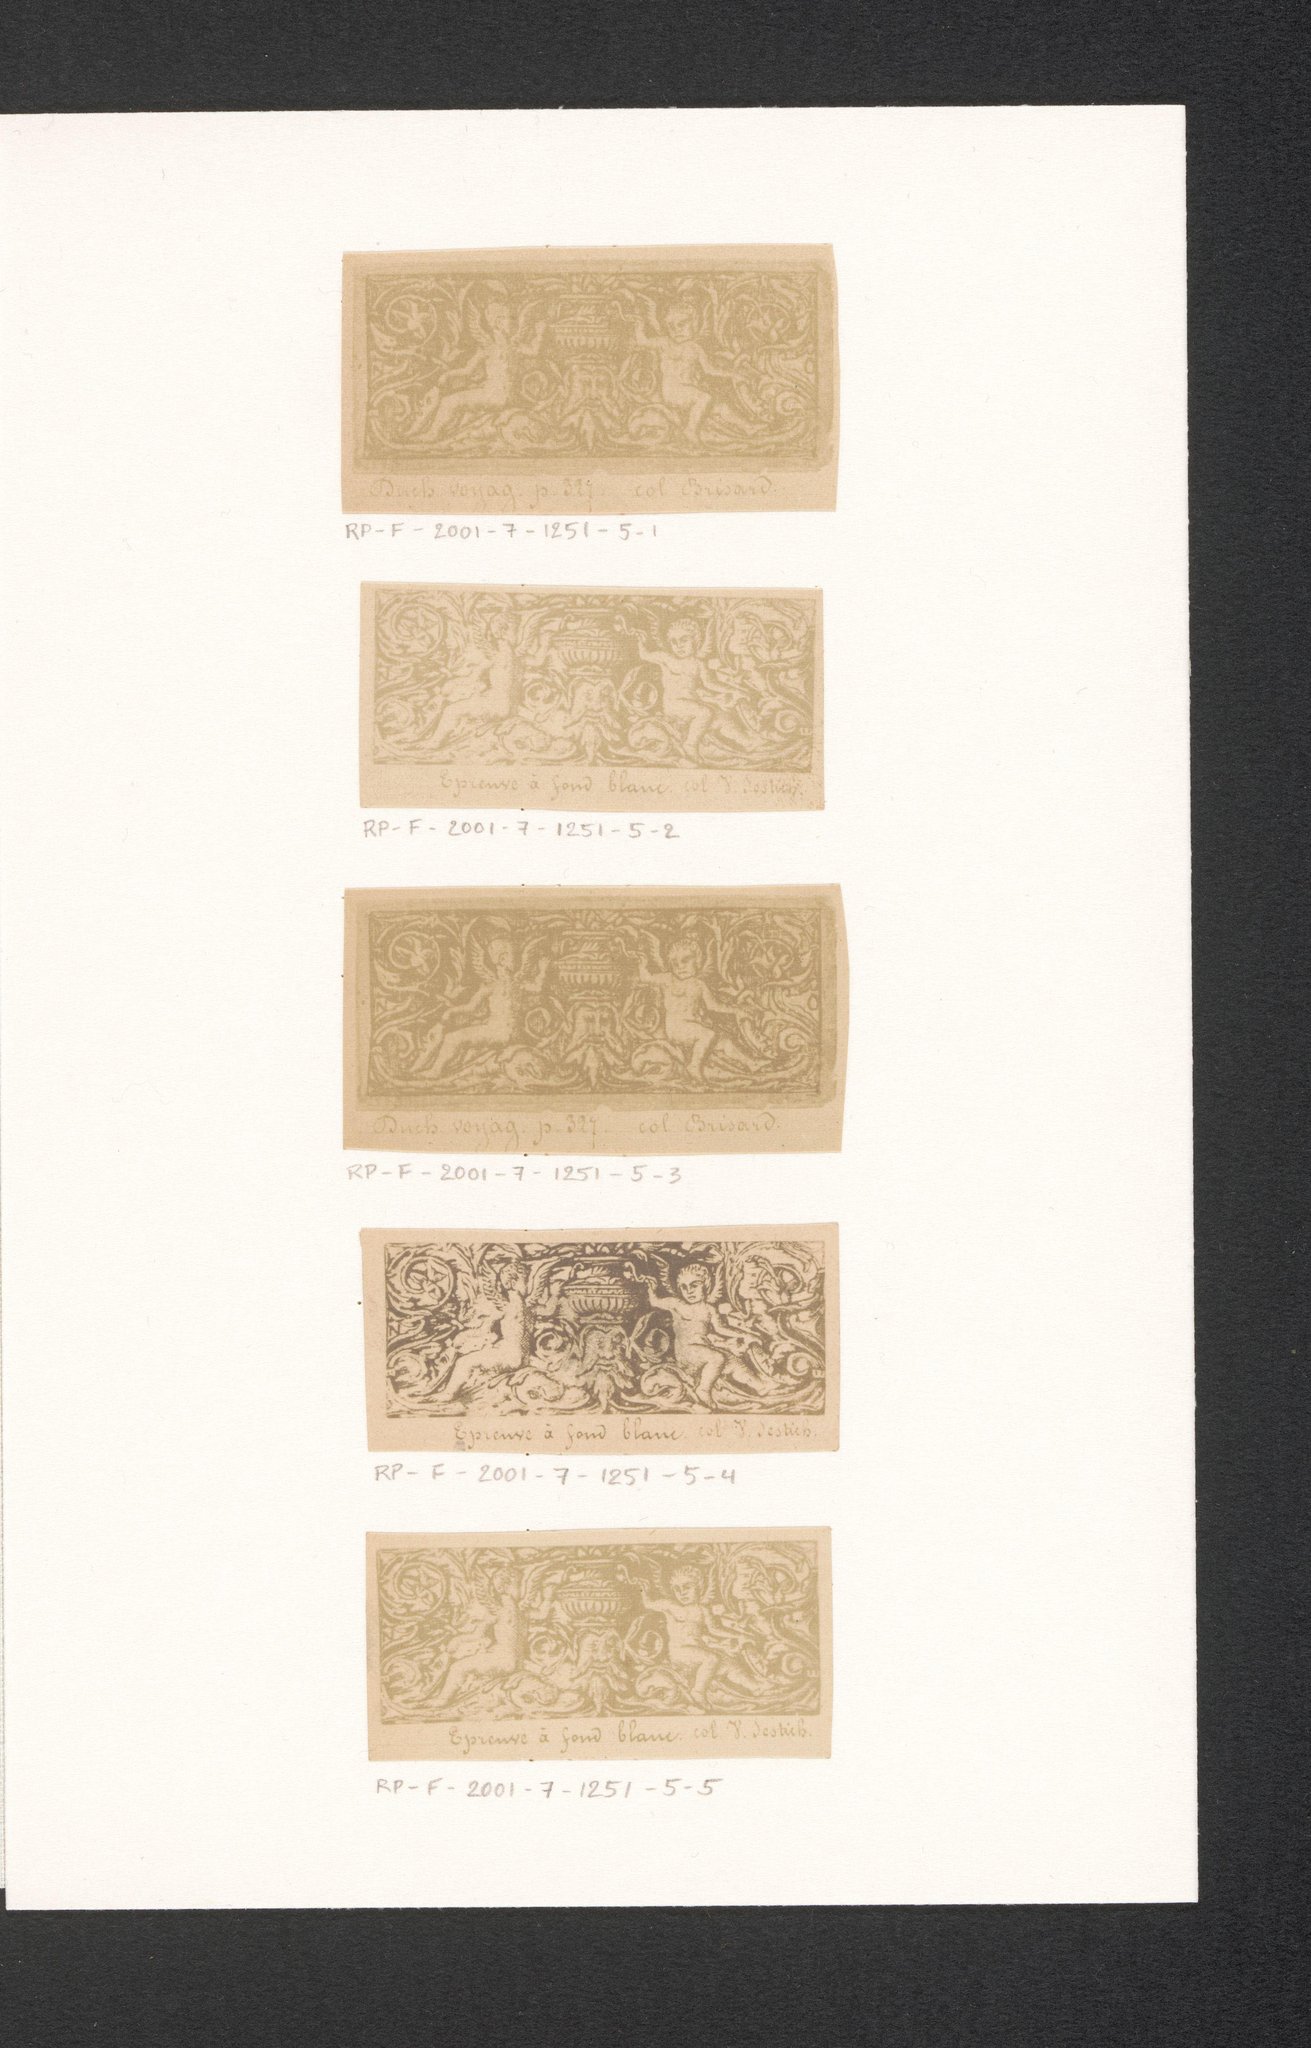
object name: photograph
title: Fotoreproductie van een prent van groteske ornamenten en twee putti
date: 1852-1857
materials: photographic support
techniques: salted paper print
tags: ornament ~ grotesque, cupids: 'amores', 'amoretti', 'putti'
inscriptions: inscription: ‘Epreuve à fond blanc. col. V. Sestich.’